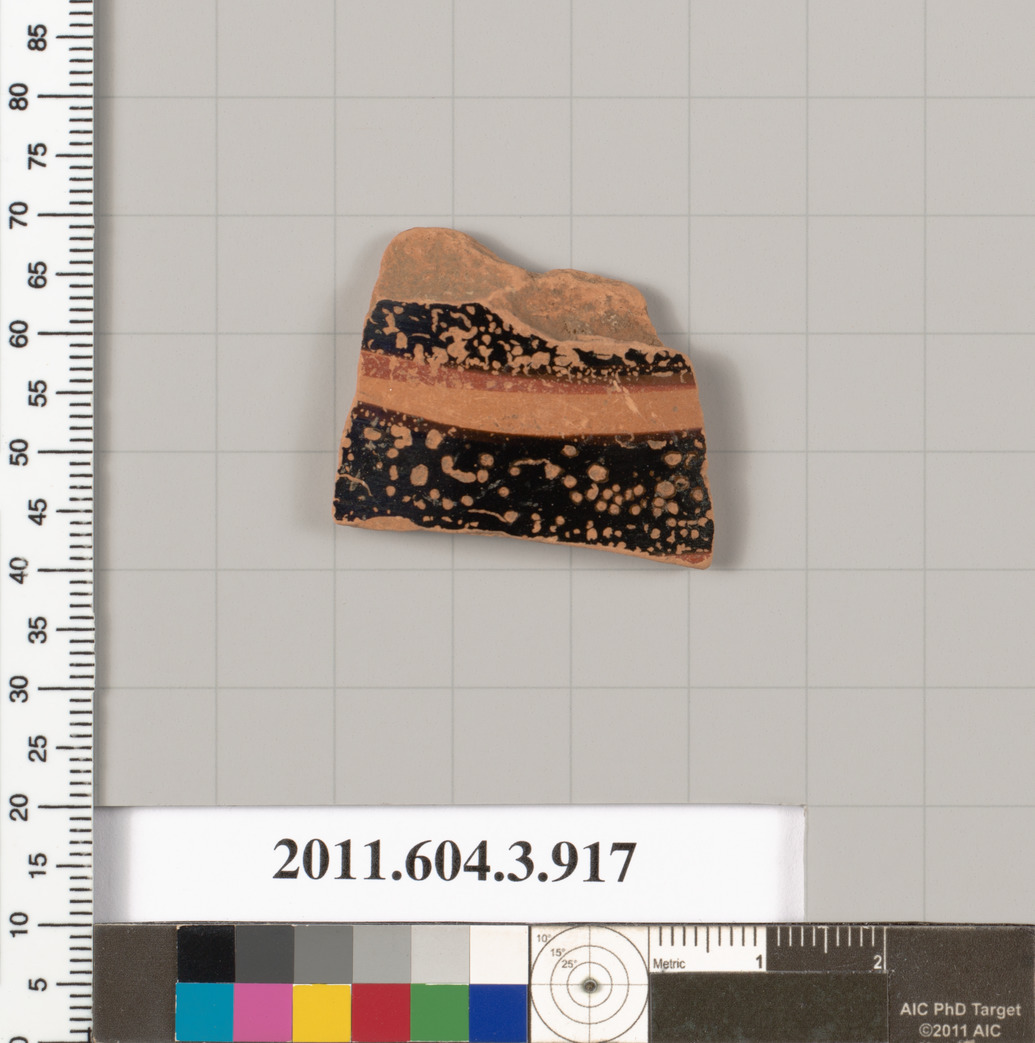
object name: lekythos fragment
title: Terracotta fragment of a lekythos (oil flask)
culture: greek, attic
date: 600-401 BCE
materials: terracotta